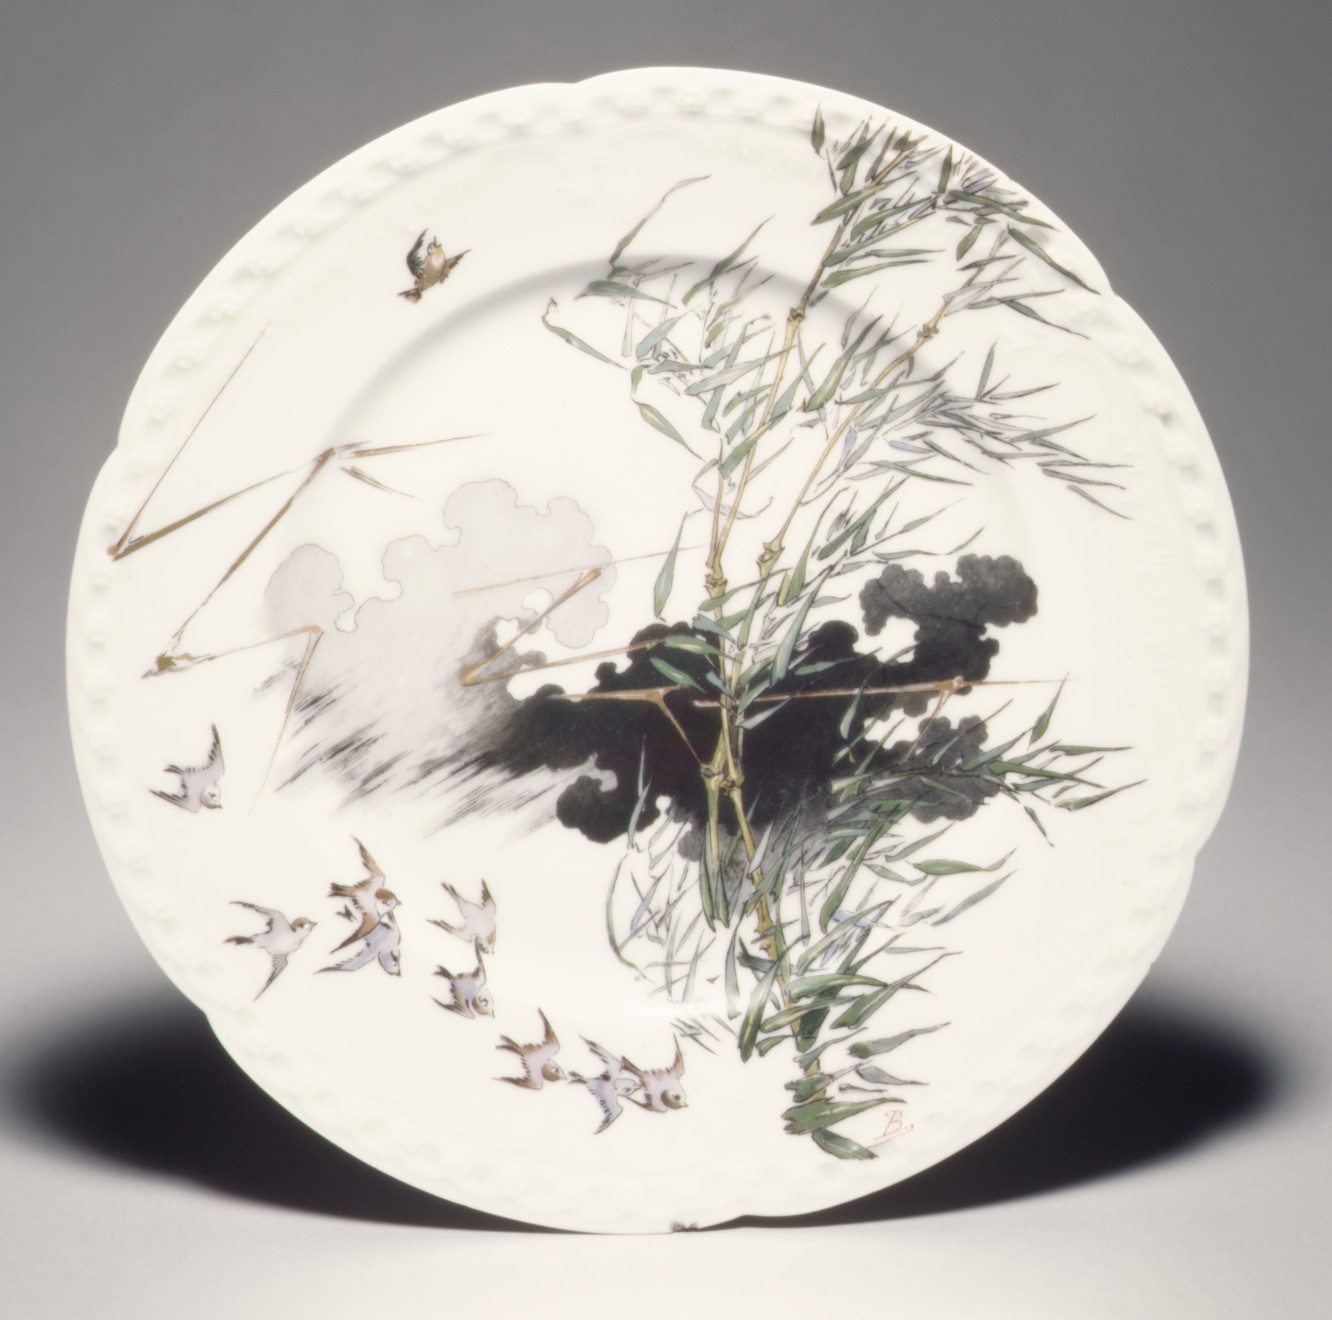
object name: plate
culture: french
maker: félix bracquemond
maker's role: artist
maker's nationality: french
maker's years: 1833-1914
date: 1875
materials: porcelain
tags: birds,bamboo